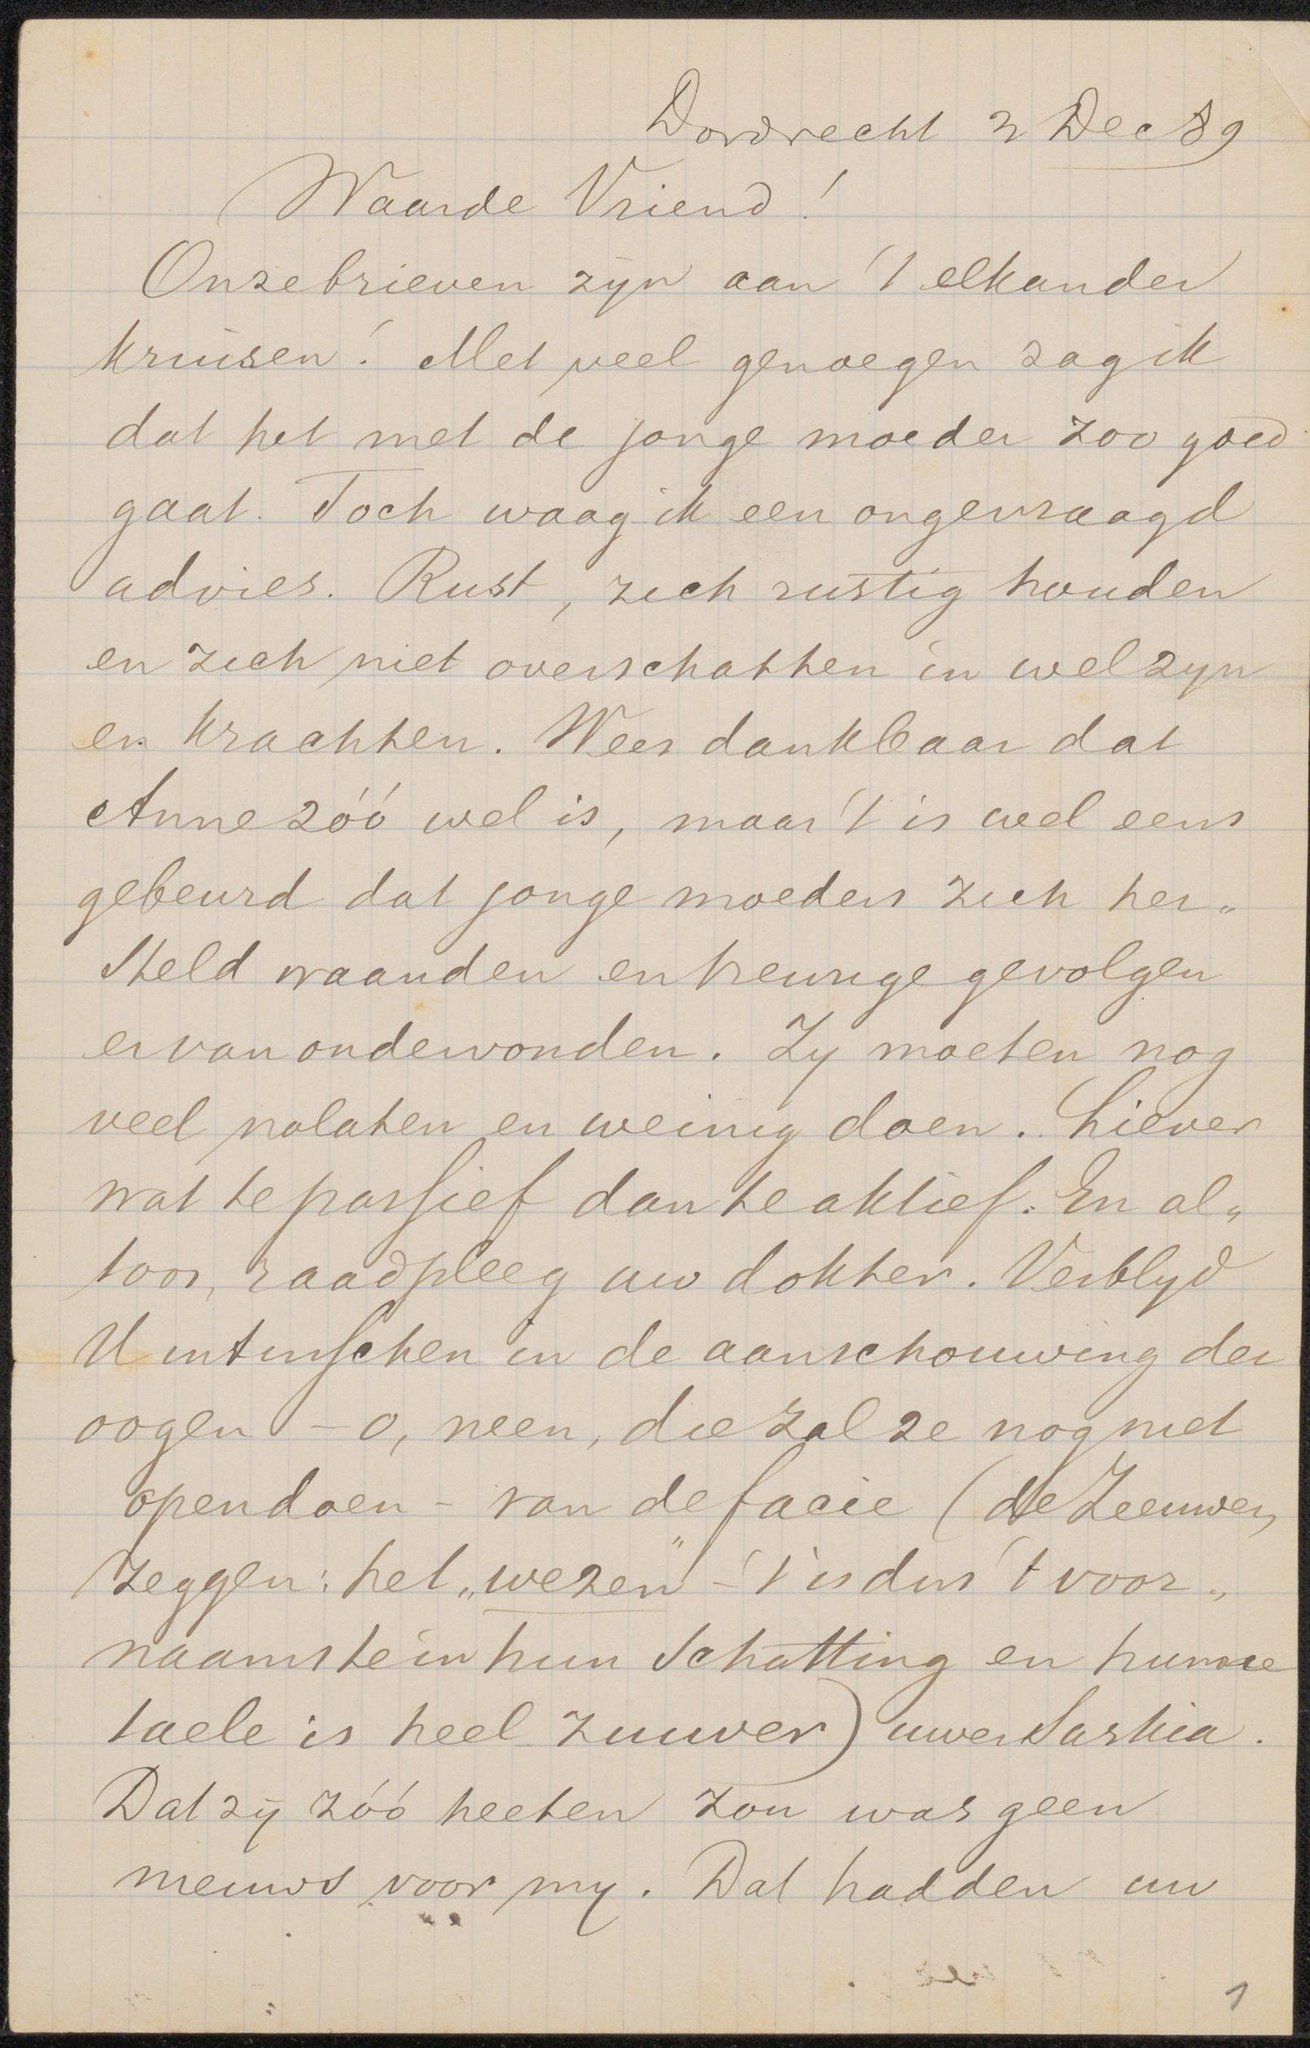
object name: letter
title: Brief aan Jan Veth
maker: martinus cornelis lebret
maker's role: verzamelaar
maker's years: 1833-1894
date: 1889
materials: ink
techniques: pen, writing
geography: dordrecht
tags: amsterdam, painter, print maker, draughtsman, designer, jan veth, art trade, art shop, applied arts, arts and crafts; industrial design, family life, money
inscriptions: collector's mark: ‘RPK’